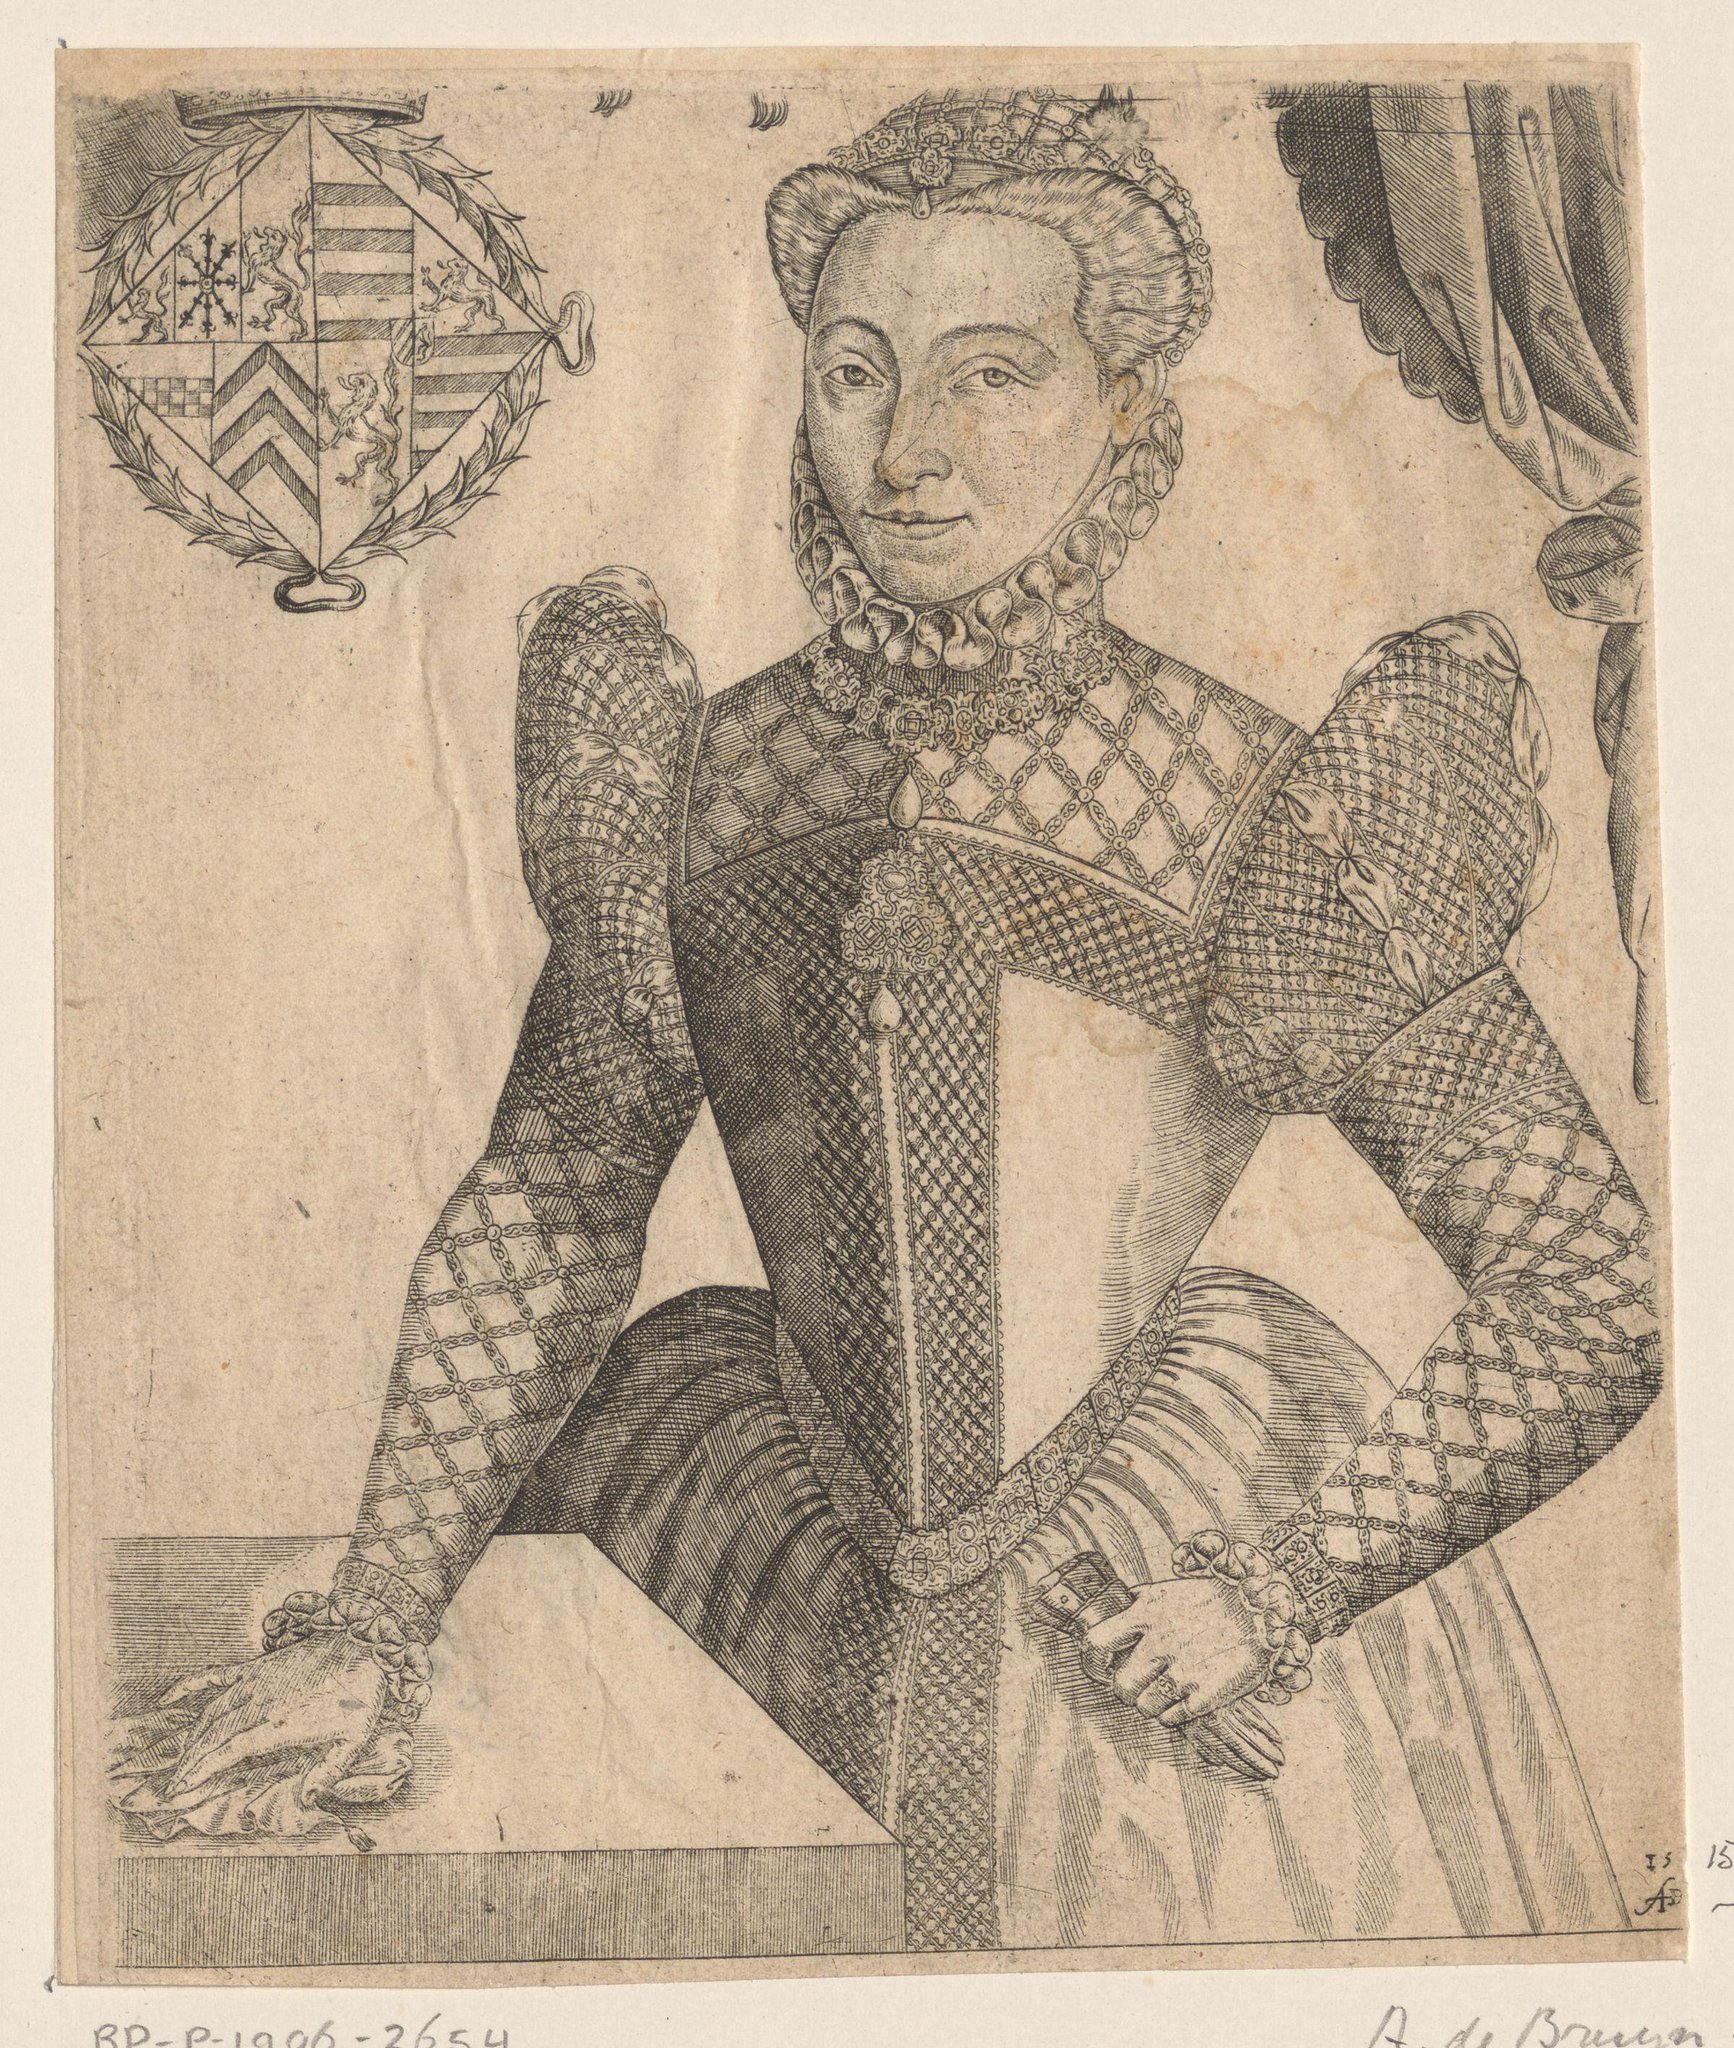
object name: print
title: Portret van Anna van Kleef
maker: abraham de bruyn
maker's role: print maker, publisher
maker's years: 1540-1587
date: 1572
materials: paper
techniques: engraving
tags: cleves, historical persons - bb - woman, armorial bearing, heraldry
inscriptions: collector's mark: Lugt 2228